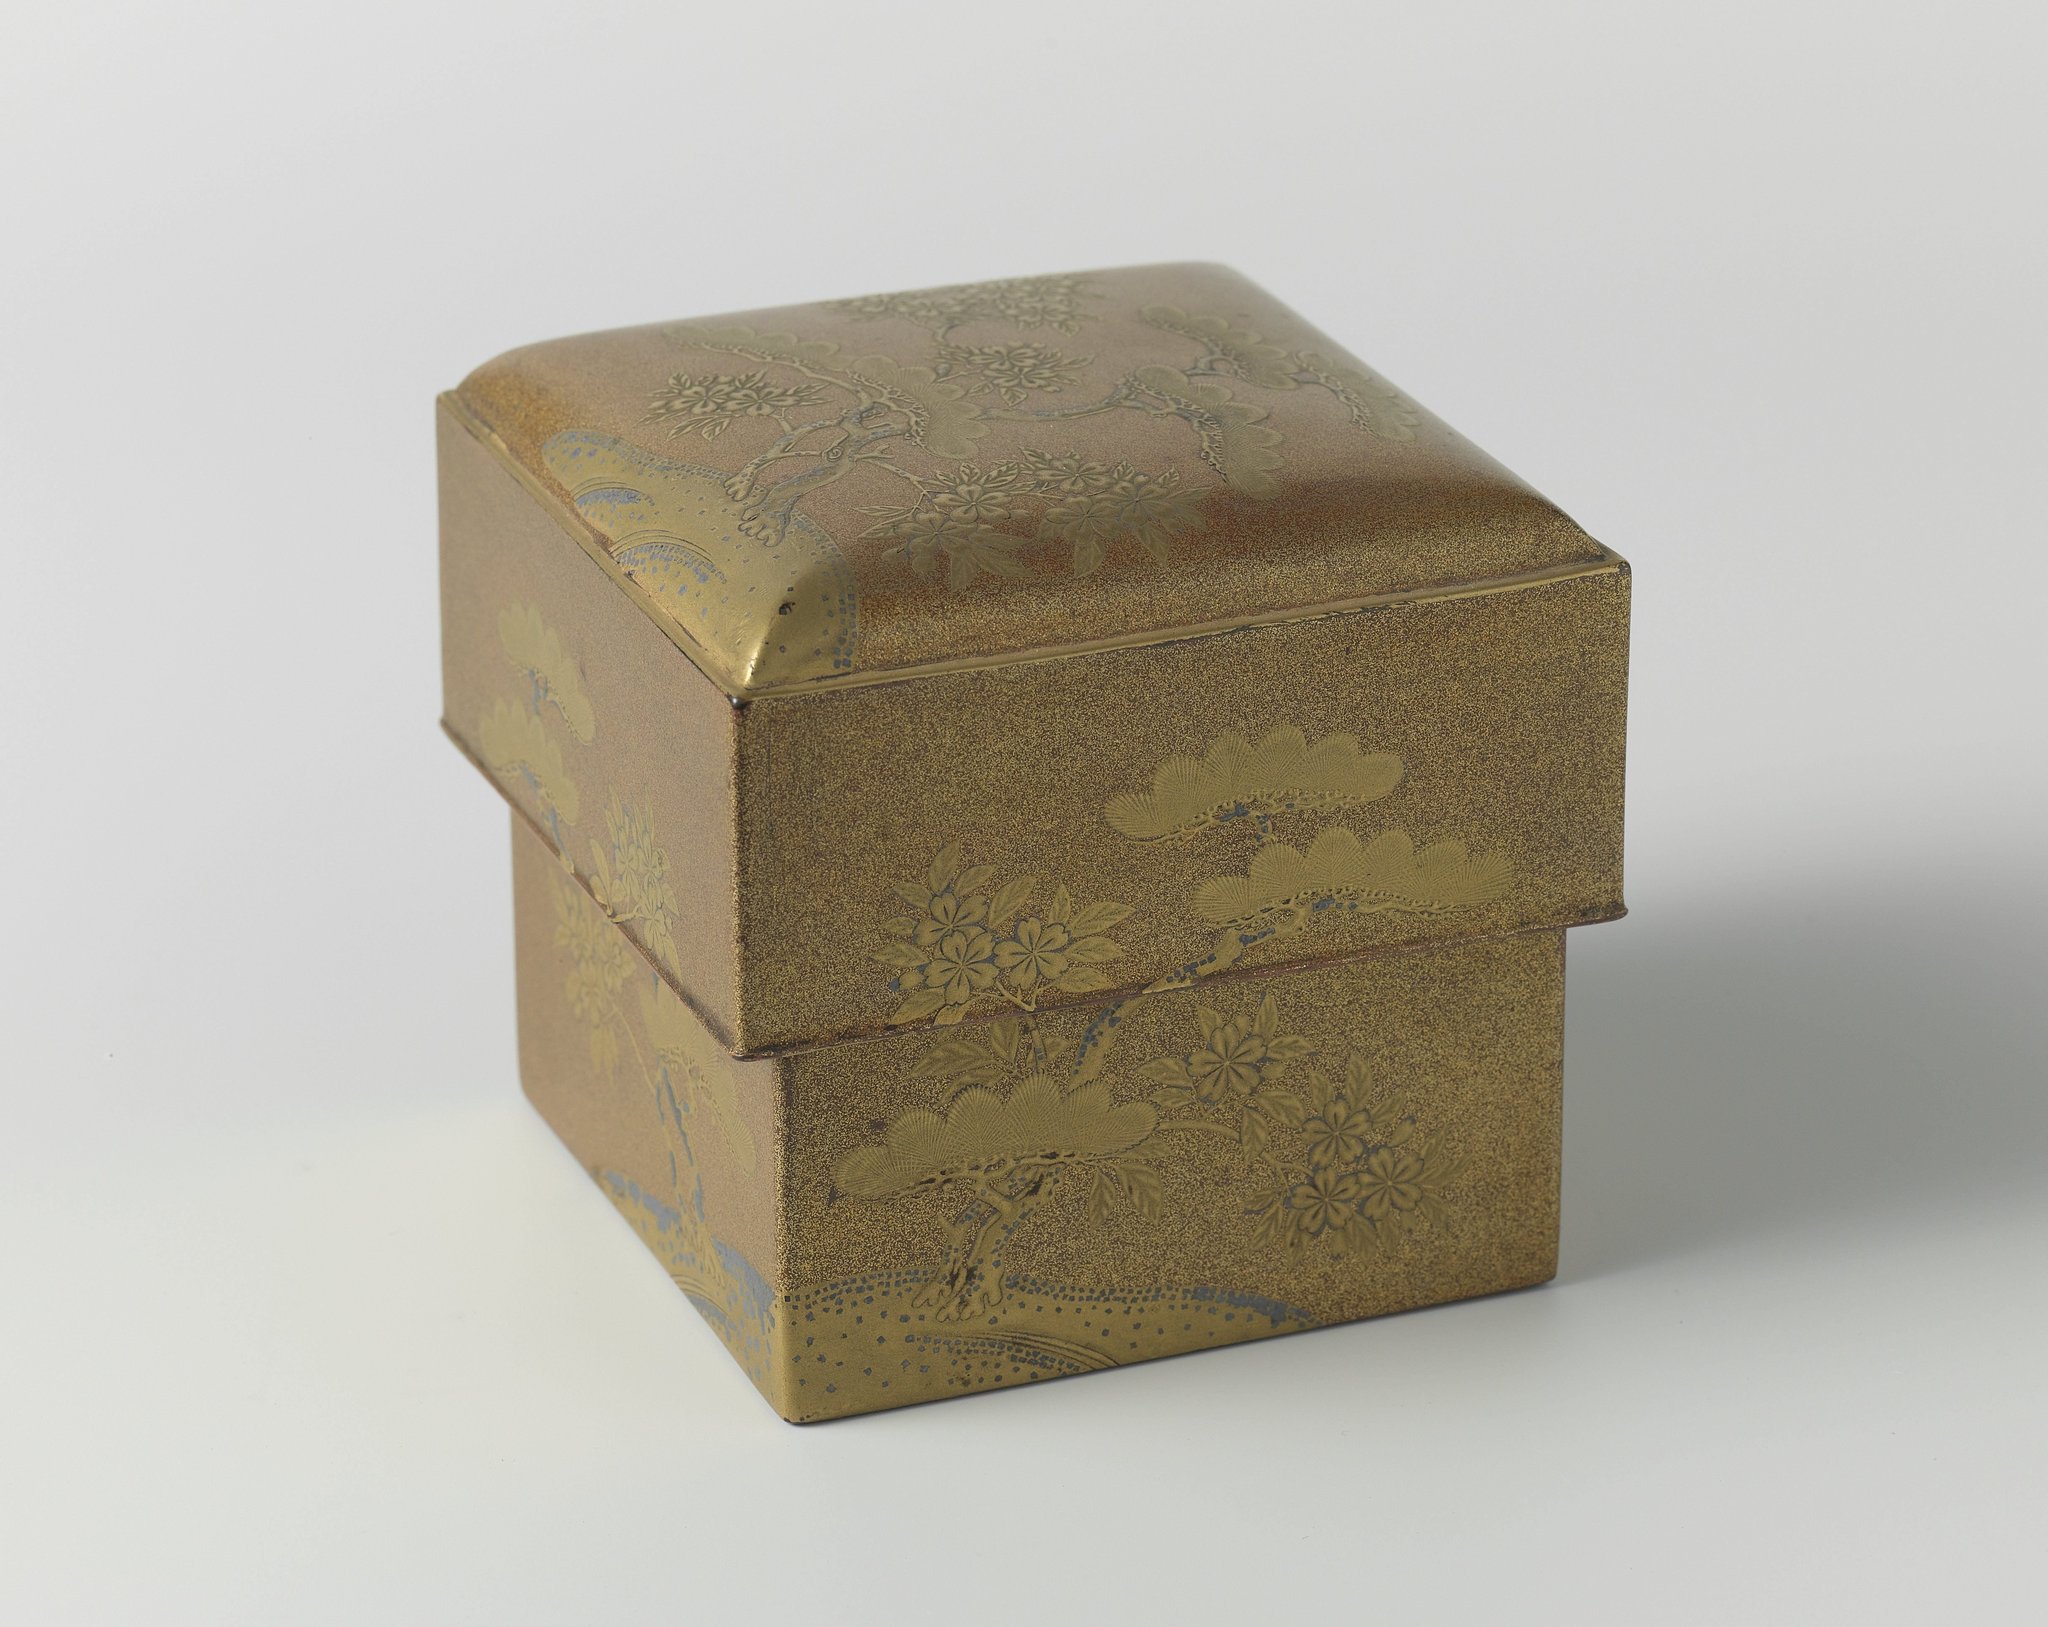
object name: box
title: Vierkante doos, met pijnbomen en kersenbloesem in makie op een nashiji-grond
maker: Anonymous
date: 1700-1800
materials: gold, lacquer, wood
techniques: lacquer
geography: japan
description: Hoge vierkante doos met overslaand, en enigszins bol deksel. Op de zijden van de doos, doorlopend op de zijden van de deksel bloeiende kersenbomen en pijnbomen in makie op een nashiji-ondergrond. Van binnen zwart.